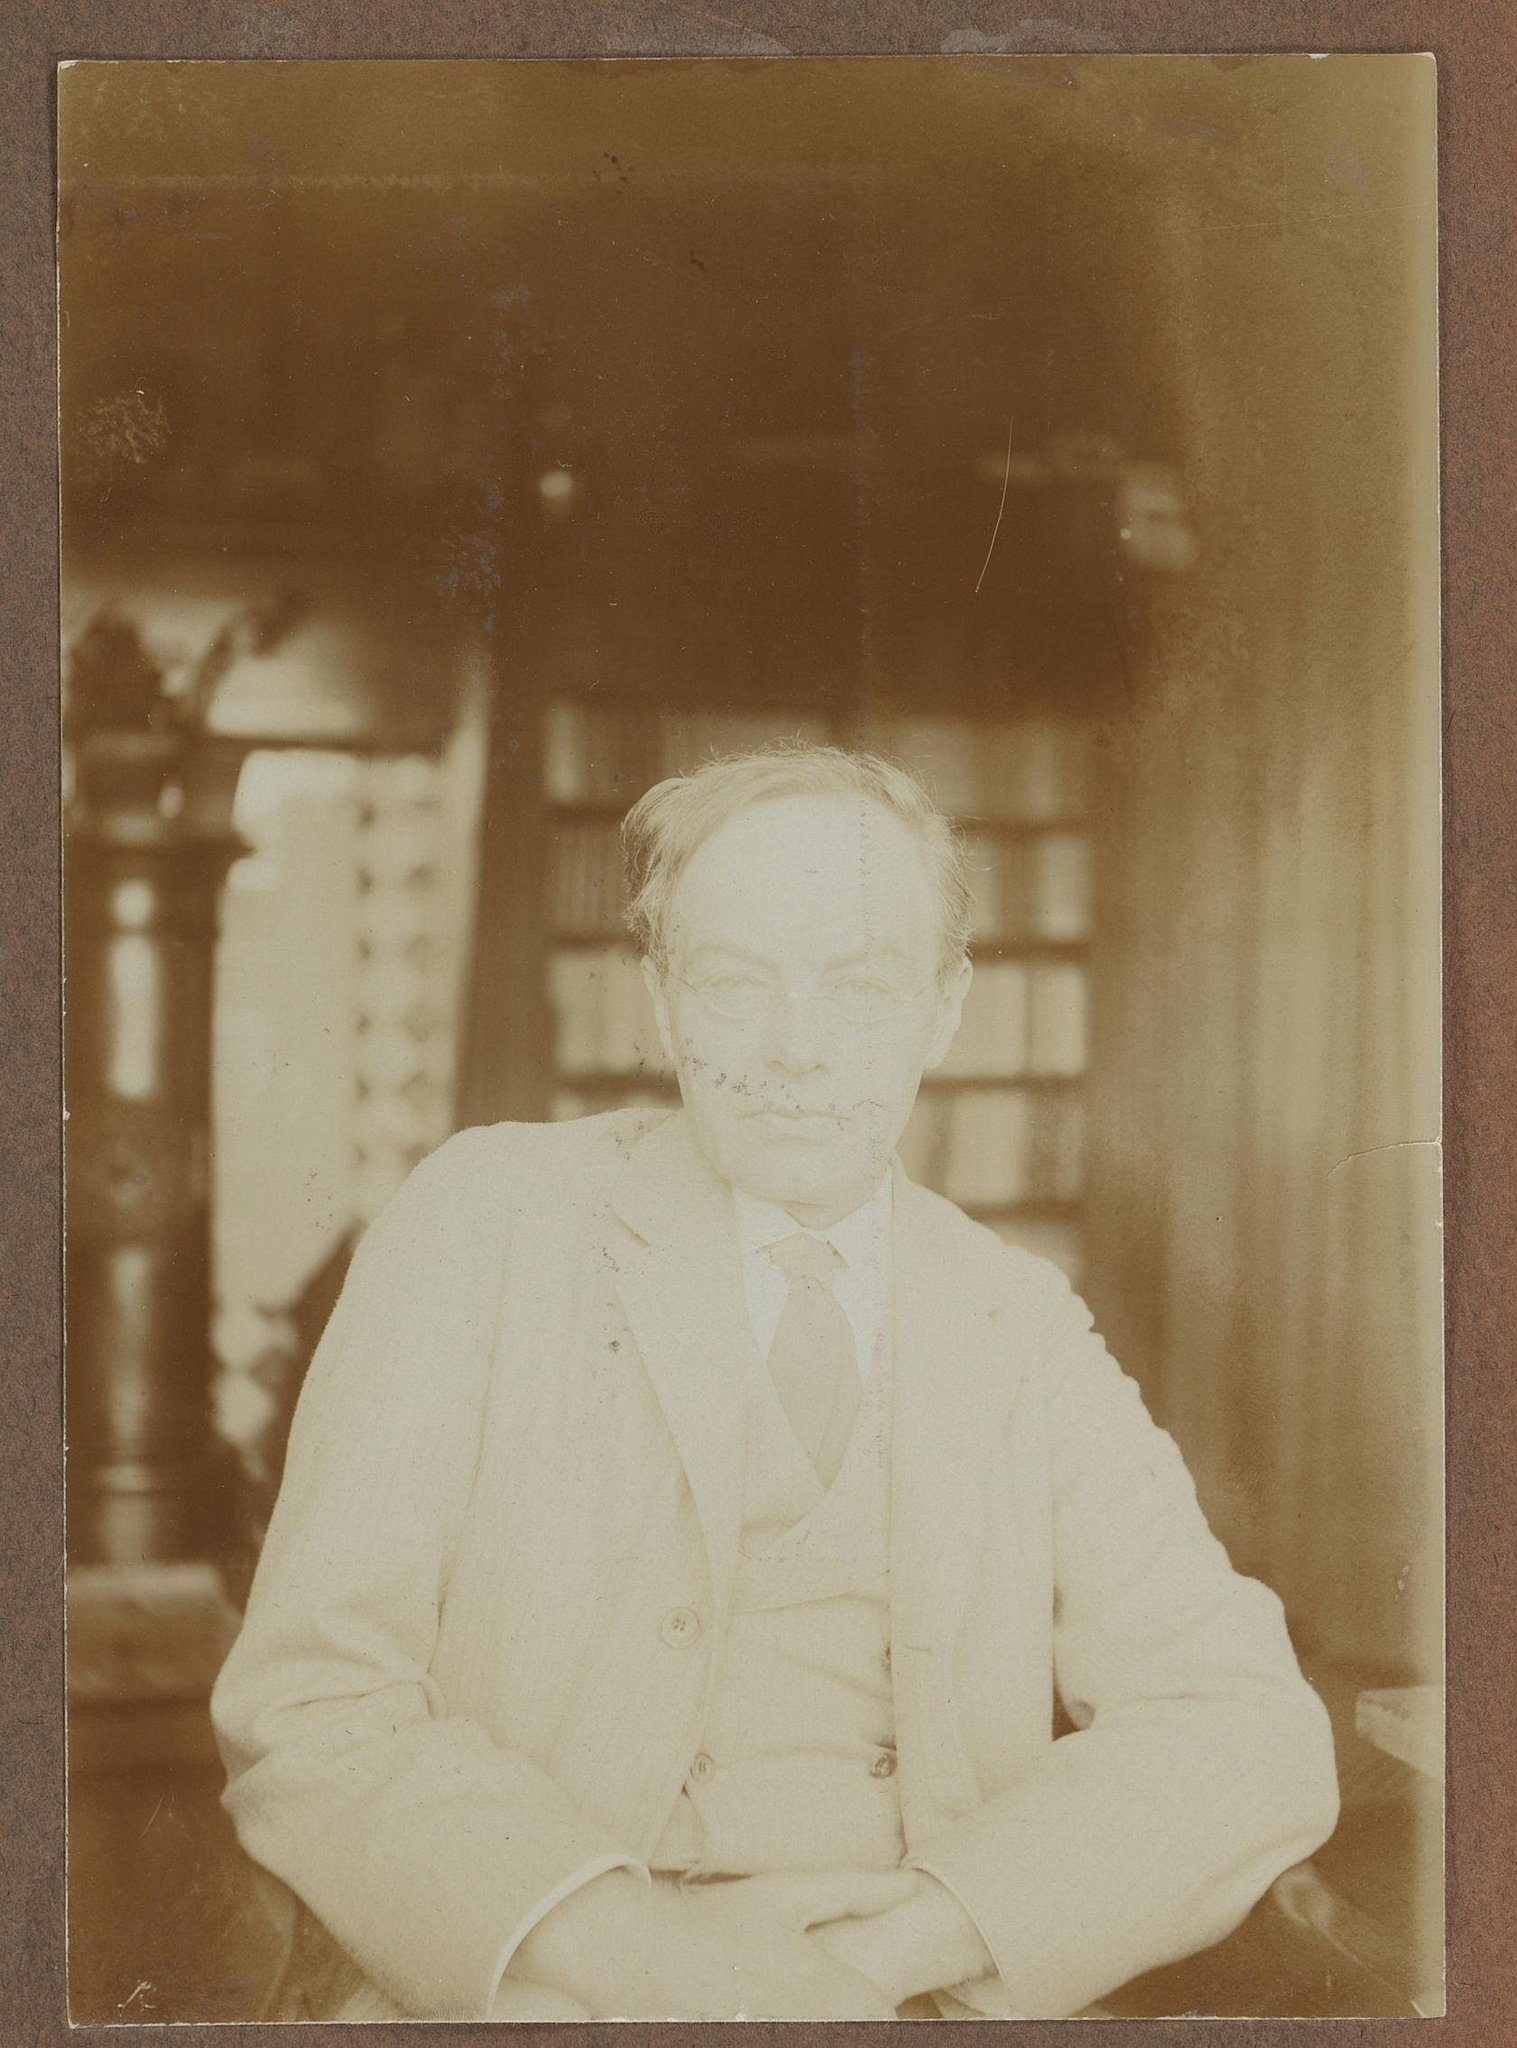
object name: photograph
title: Alphons Diepenbrock en face in interieur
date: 1910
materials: photographic support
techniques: photography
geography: amsterdam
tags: amsterdam, alphons diepenbrock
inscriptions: date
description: Foto op bruin albumblad 5 van familiealbum van Alphons Diepenbrock.